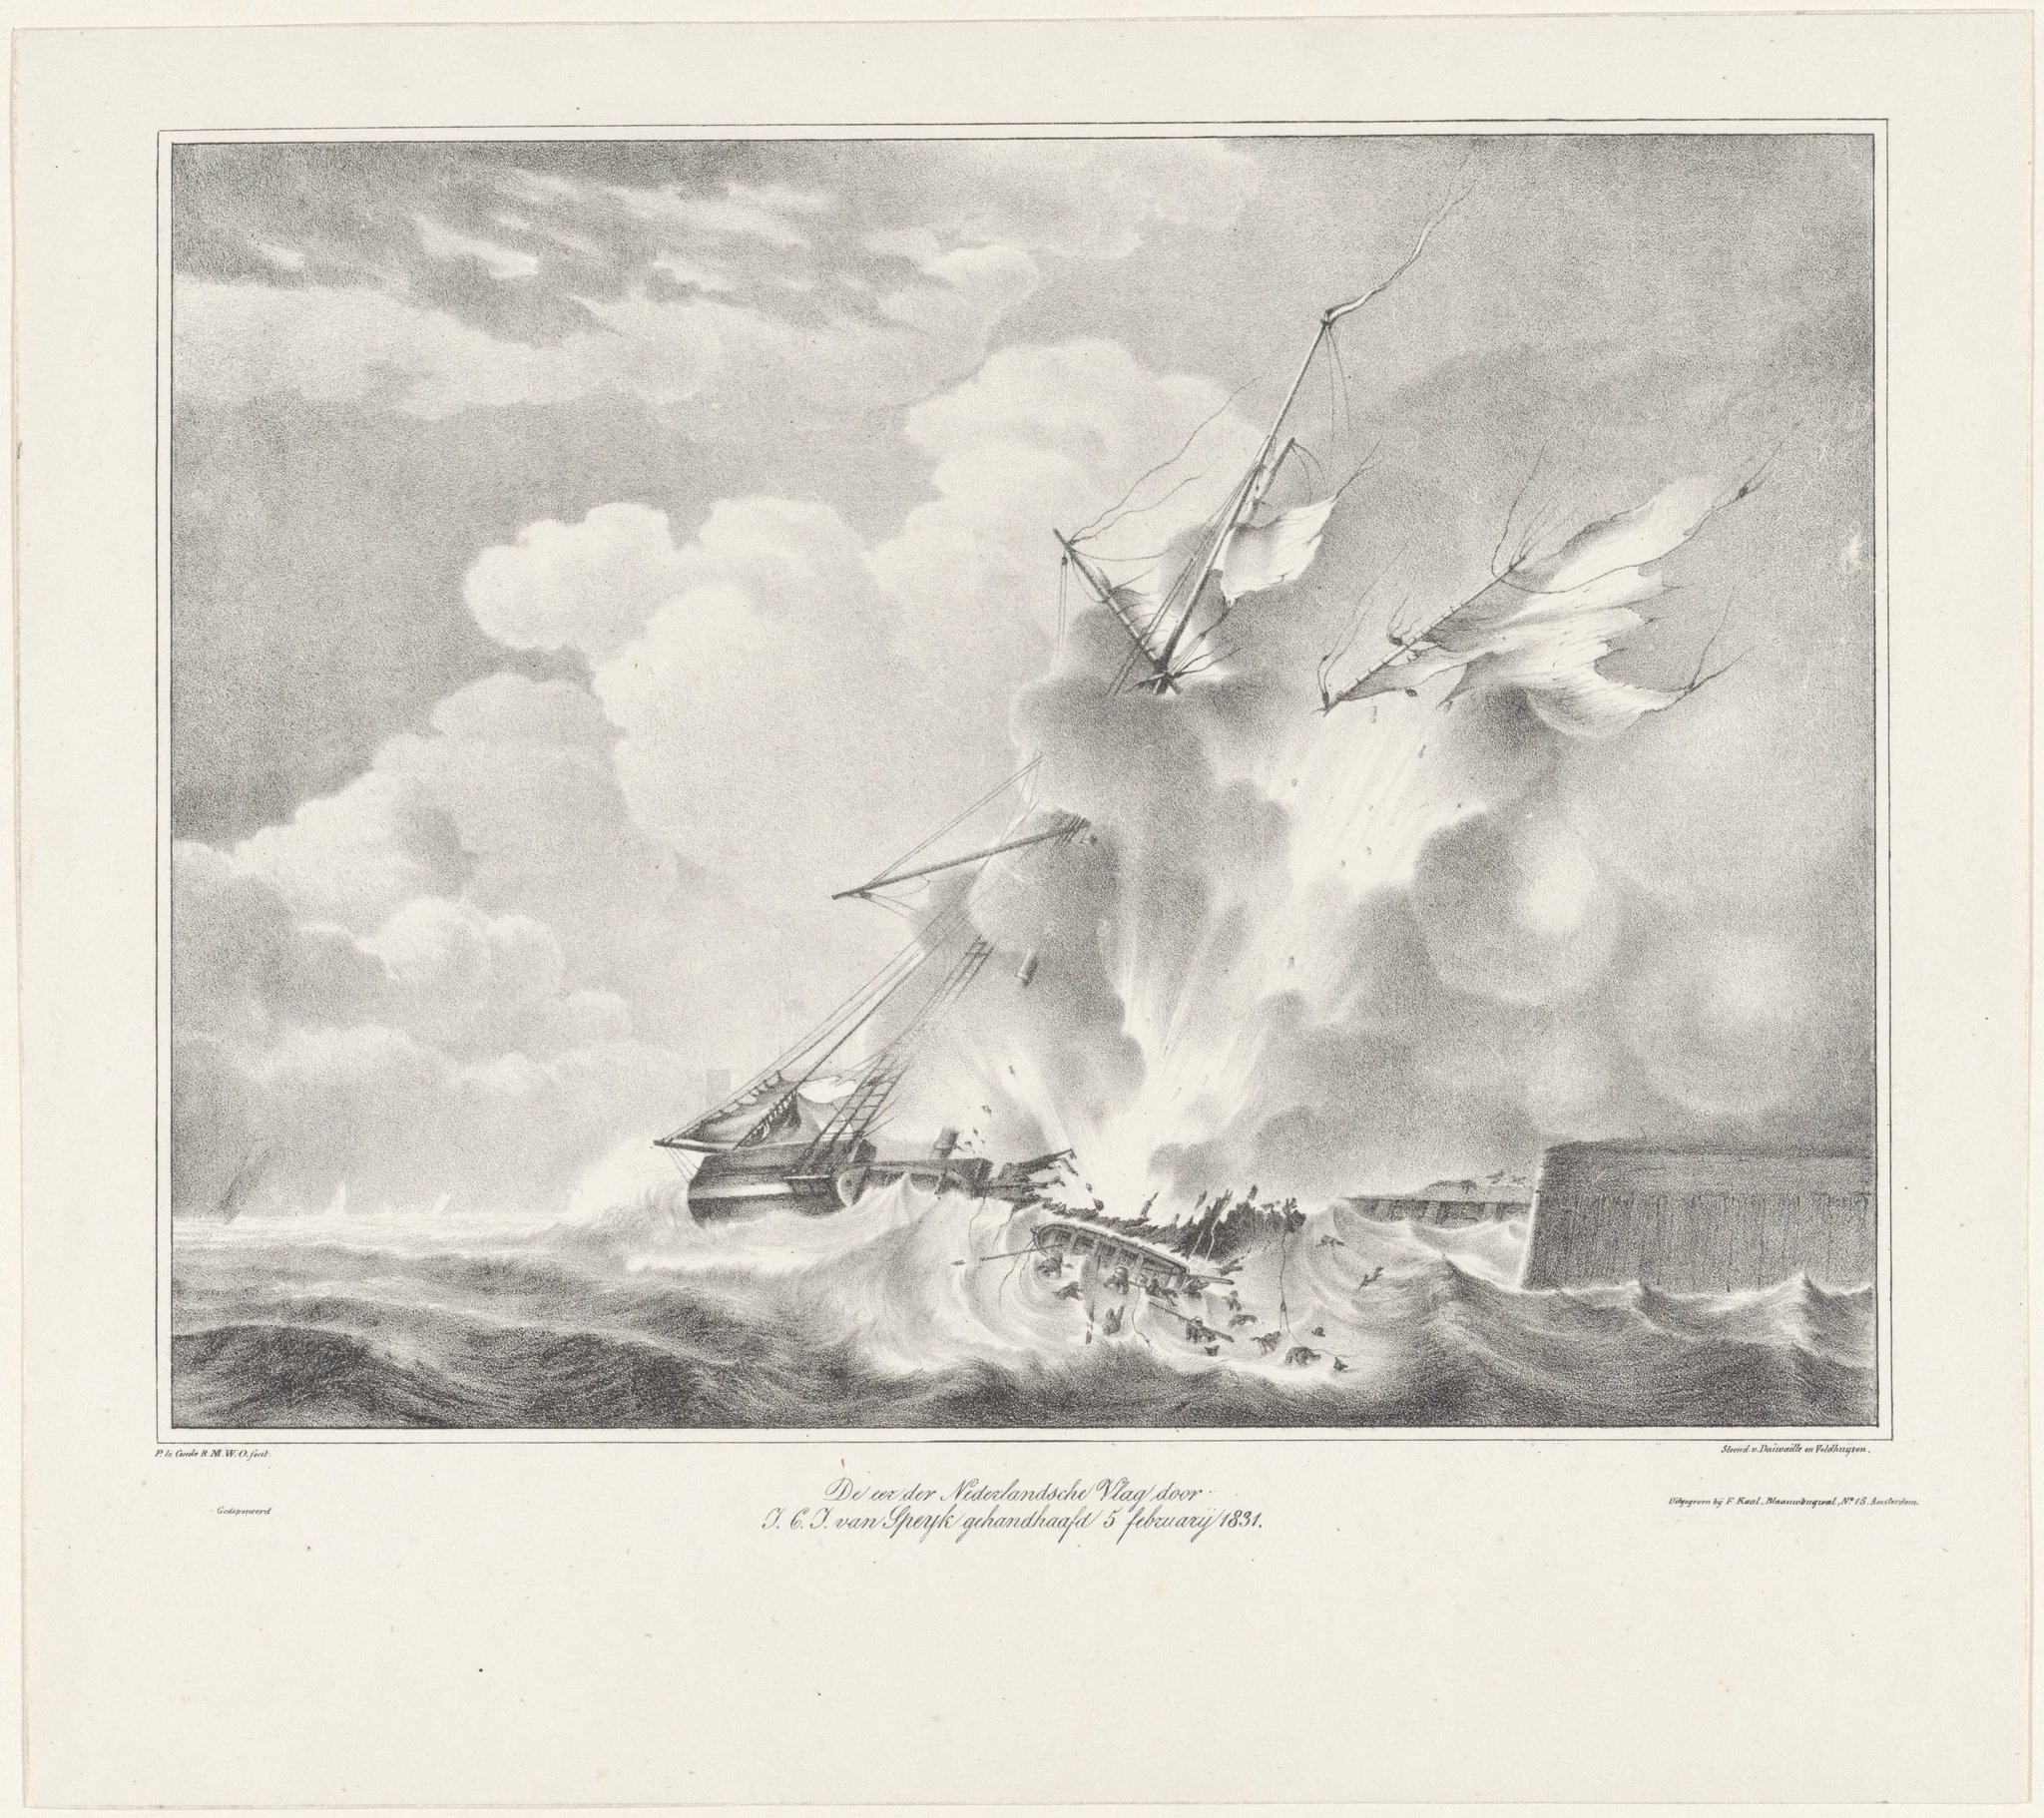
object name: print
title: Het springen van de kanonneerboot van Jan van Speyk, 1831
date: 1831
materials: paper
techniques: lithograph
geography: netherlands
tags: amsterdam, antwerp, jan van speyk, navy (+ sailing-ships), self-sacrifice, death in the service of a higher purpose, gunpowder disaster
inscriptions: collector's mark: Lugt 2228, workshop stamp: ‘PLC RMWO’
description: Het in de lucht springen van de kanonneerboot van Jan van Speyk, 5 februari 1831. Zie ook de pendant. Bij de beide platen behoort een tekstblad met uitlegging van de voorstelling.